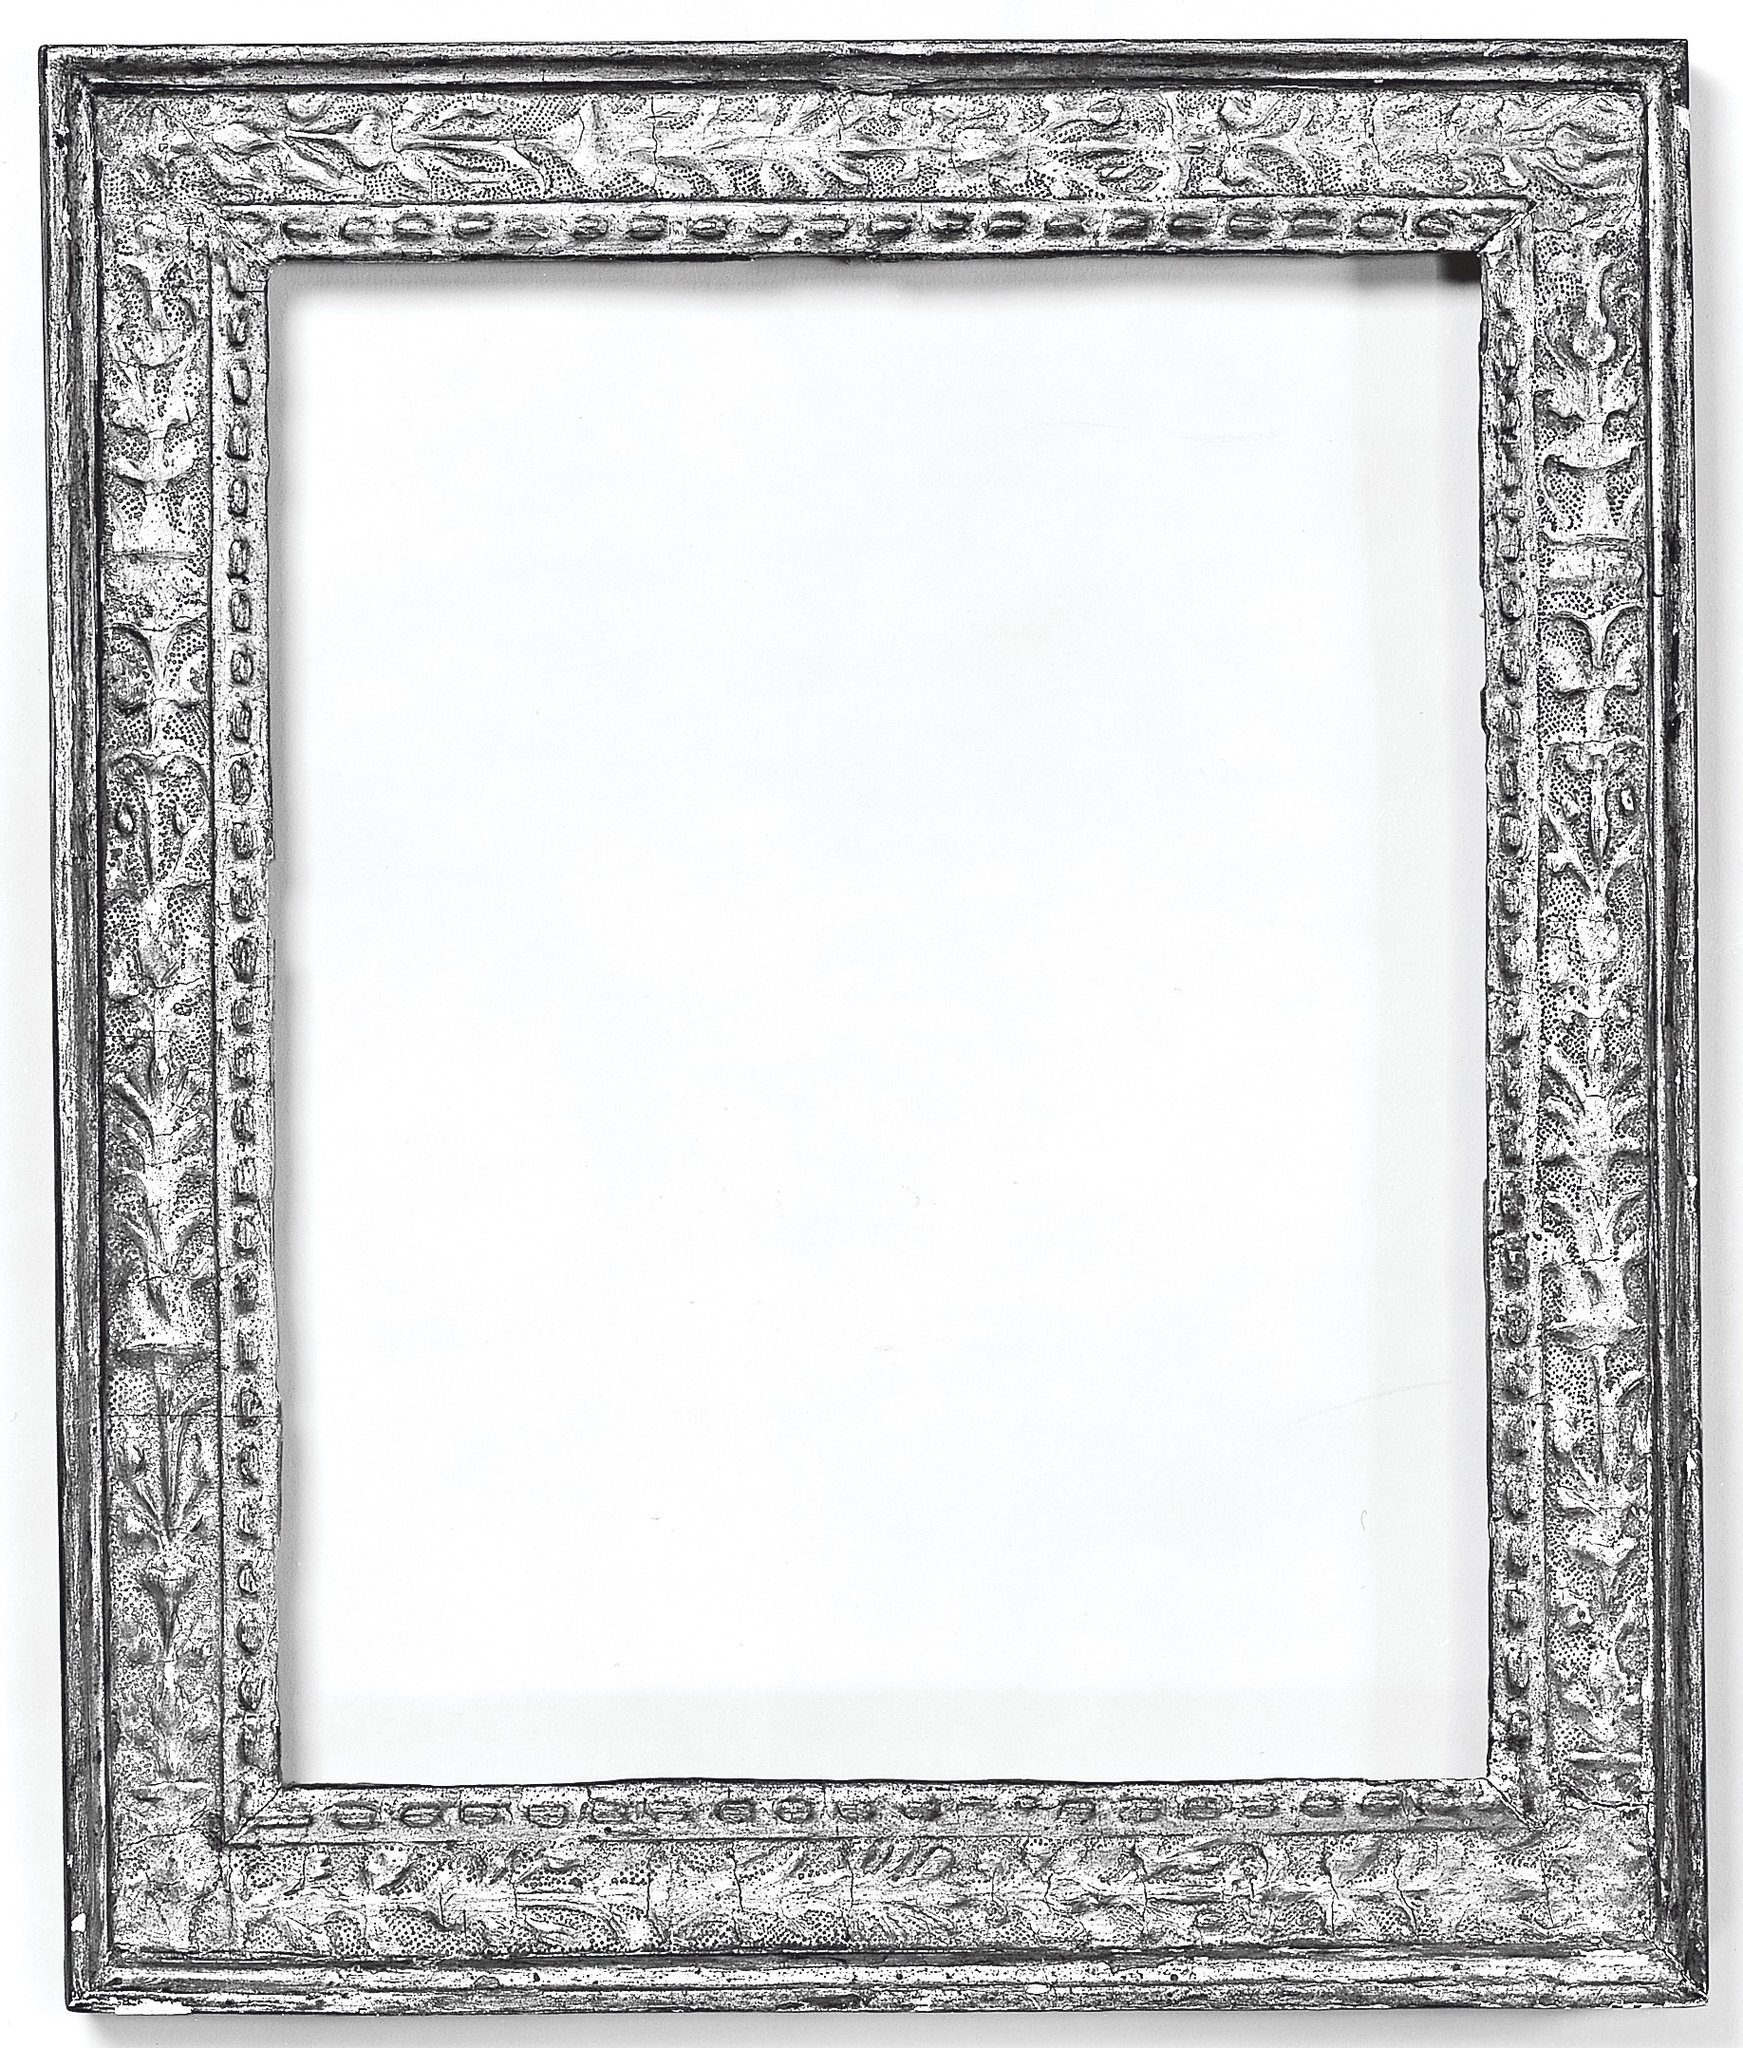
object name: frame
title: Cassetta frame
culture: italian, veneto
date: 1567-1600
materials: wood